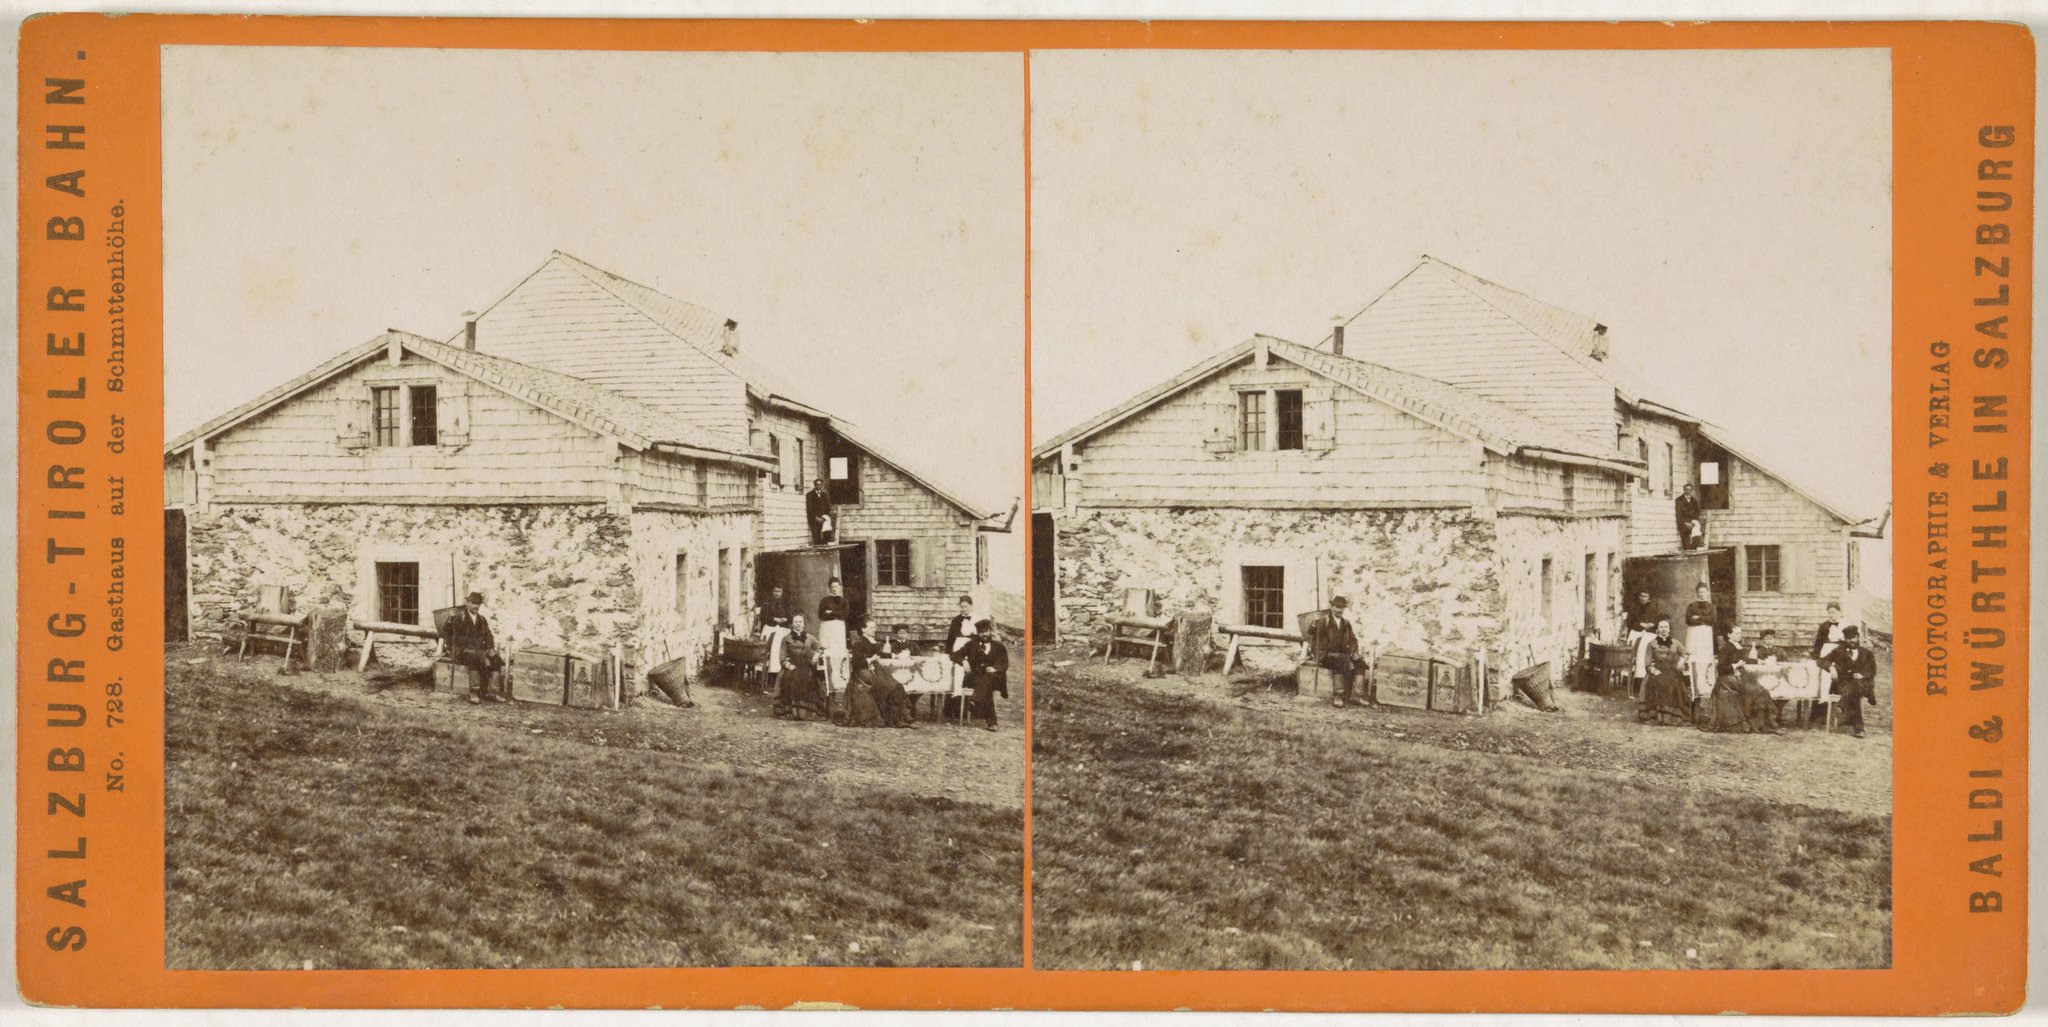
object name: stereograph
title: Salzburg-Tiroler Bahn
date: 1862-1880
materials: cardboard, paper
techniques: albumen print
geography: schmittenhöhe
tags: hotel, hostelry, inn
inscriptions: number: ‘No. 728’